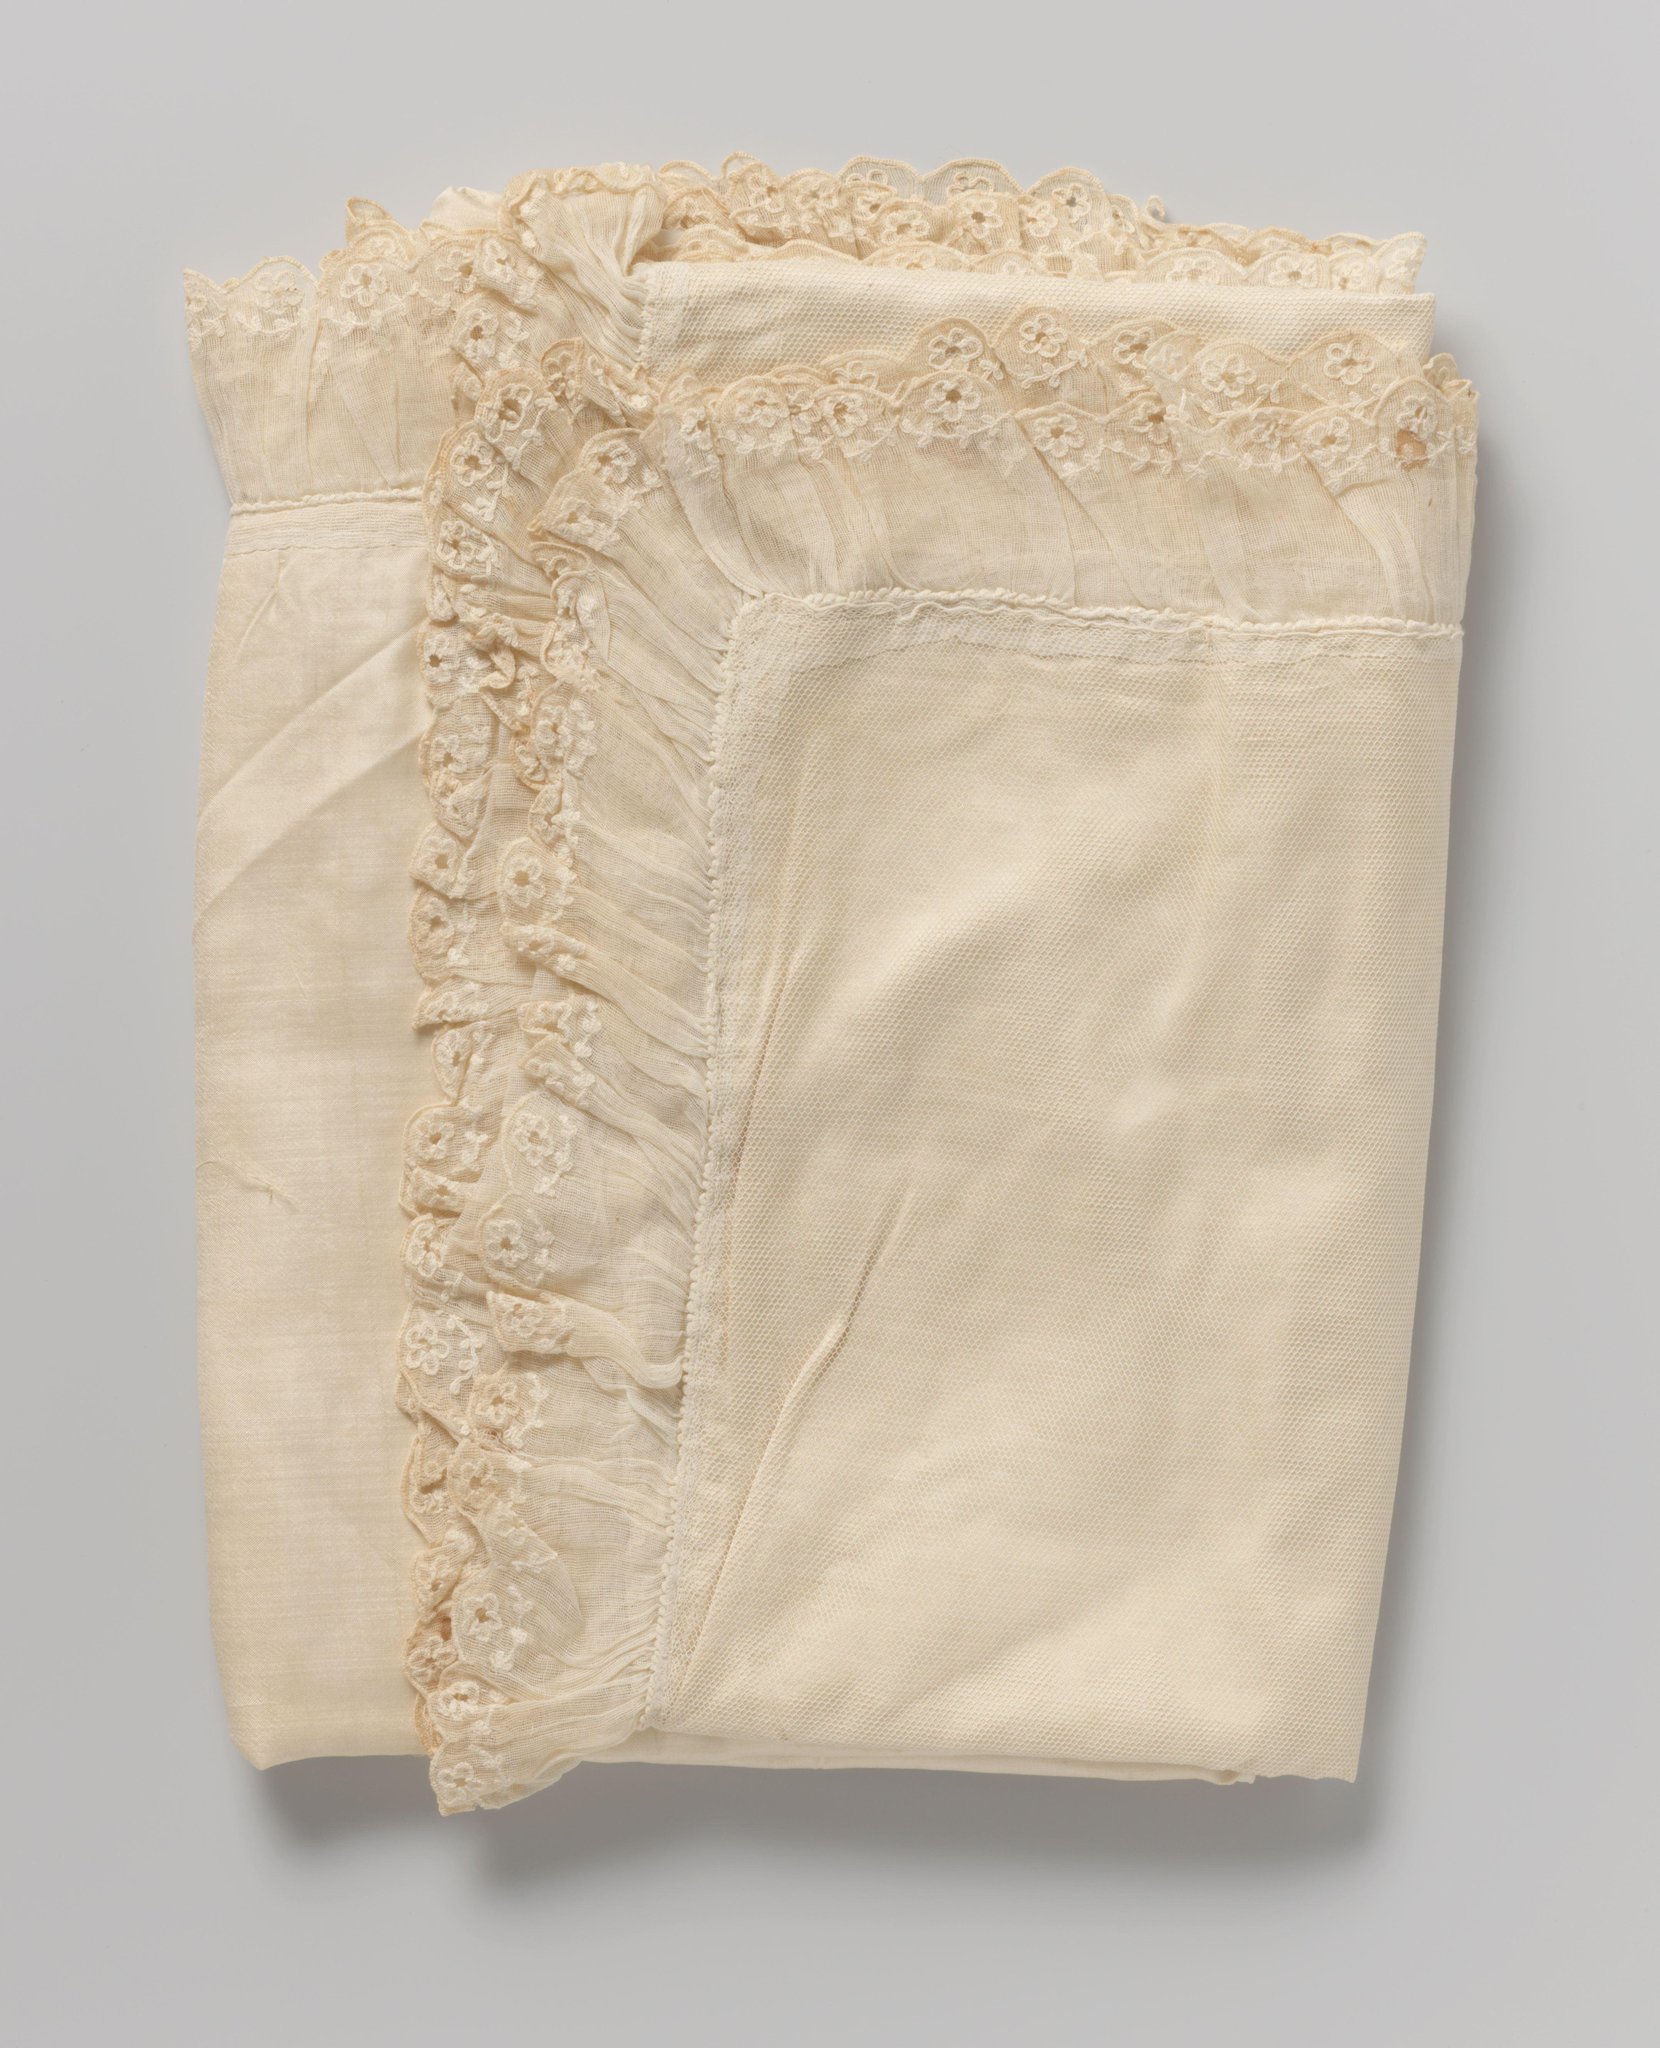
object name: childrenswear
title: Kleed of doopkleed met tamboereerwerk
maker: Anonymous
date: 1840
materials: silk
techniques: embroidered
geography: netherlands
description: Kleed met borduurwerk. Rechthoekig model. Het patroon heeft wijde gestrooide blokken van negen moesjes binnen een rand van gestrooide bladeren. De binnengrens van de rand is gegolfd en de buitengrens heeft bloemranken afgewisseld door Kashmirmotieven. Het kleed heeft langs de rand een gerimpelde strook. Het patroon van de strook heeft een schulprand met bogen en rozetten. Het kleed is gevoerd met waszijde en een reep tule waarop de merkletters: TBLL.